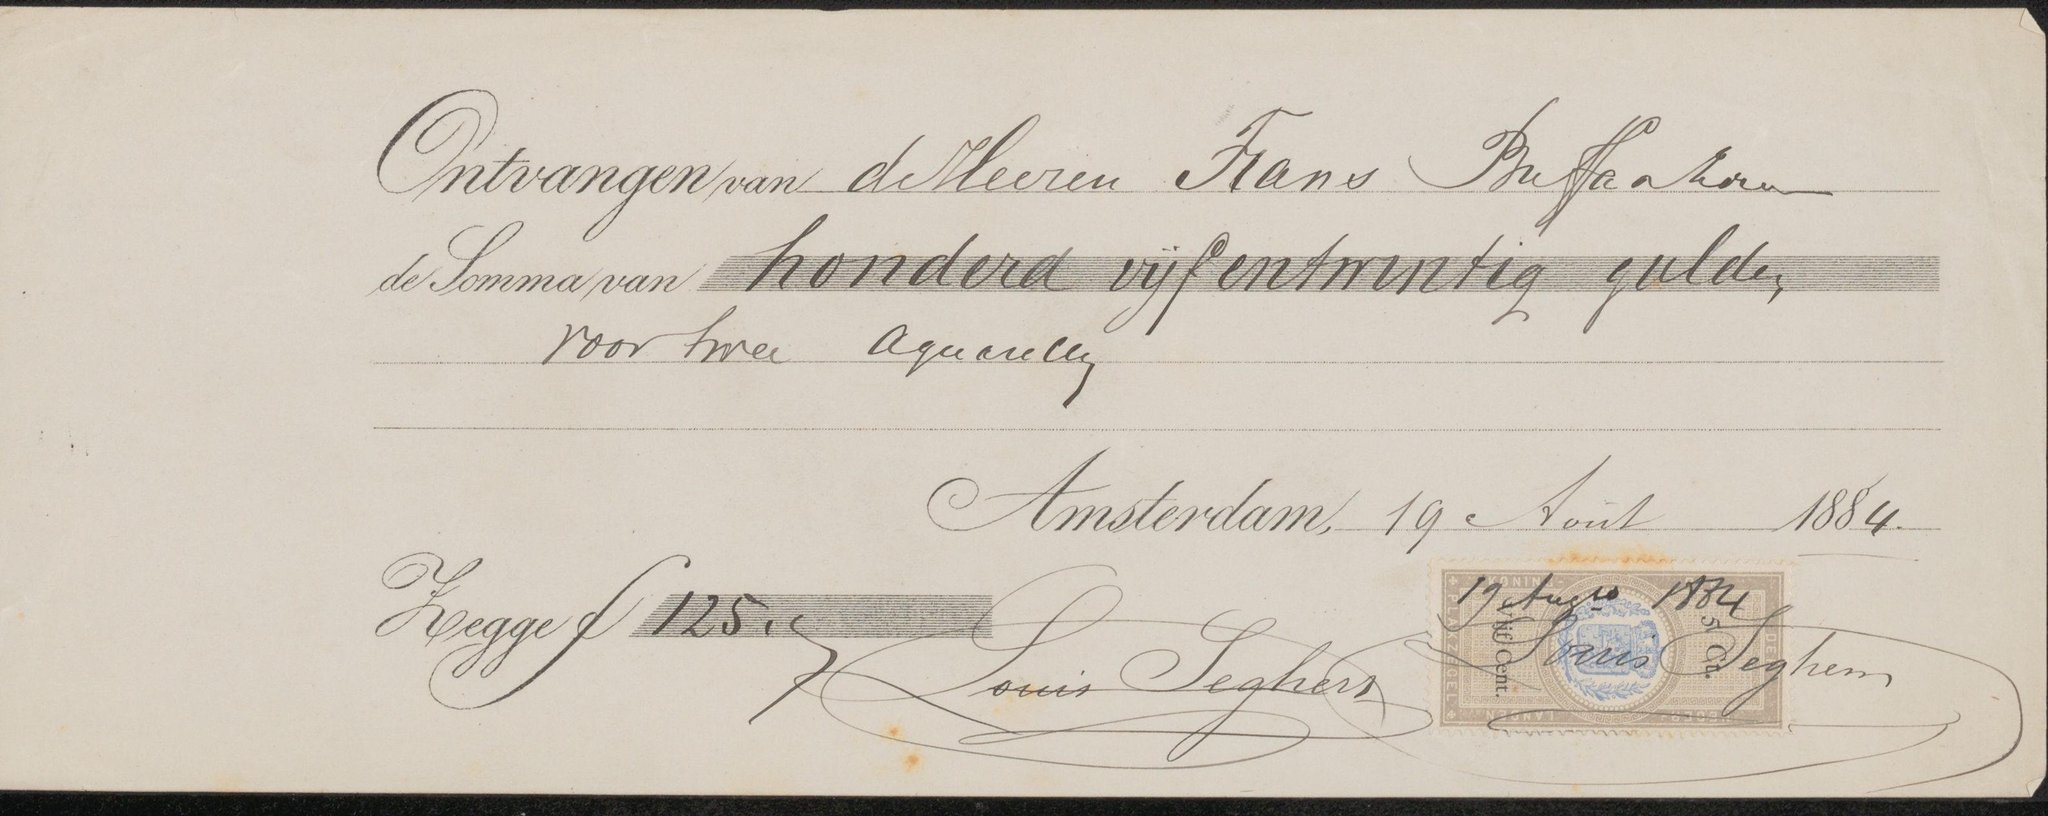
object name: ontvangstbewijs, kwitantie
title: Kwitantie voor Louis Seghers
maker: louis seghers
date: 1884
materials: ink, paper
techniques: pen, printing, writing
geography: amsterdam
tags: drawing, money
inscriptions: collector's mark: Lugt 2233